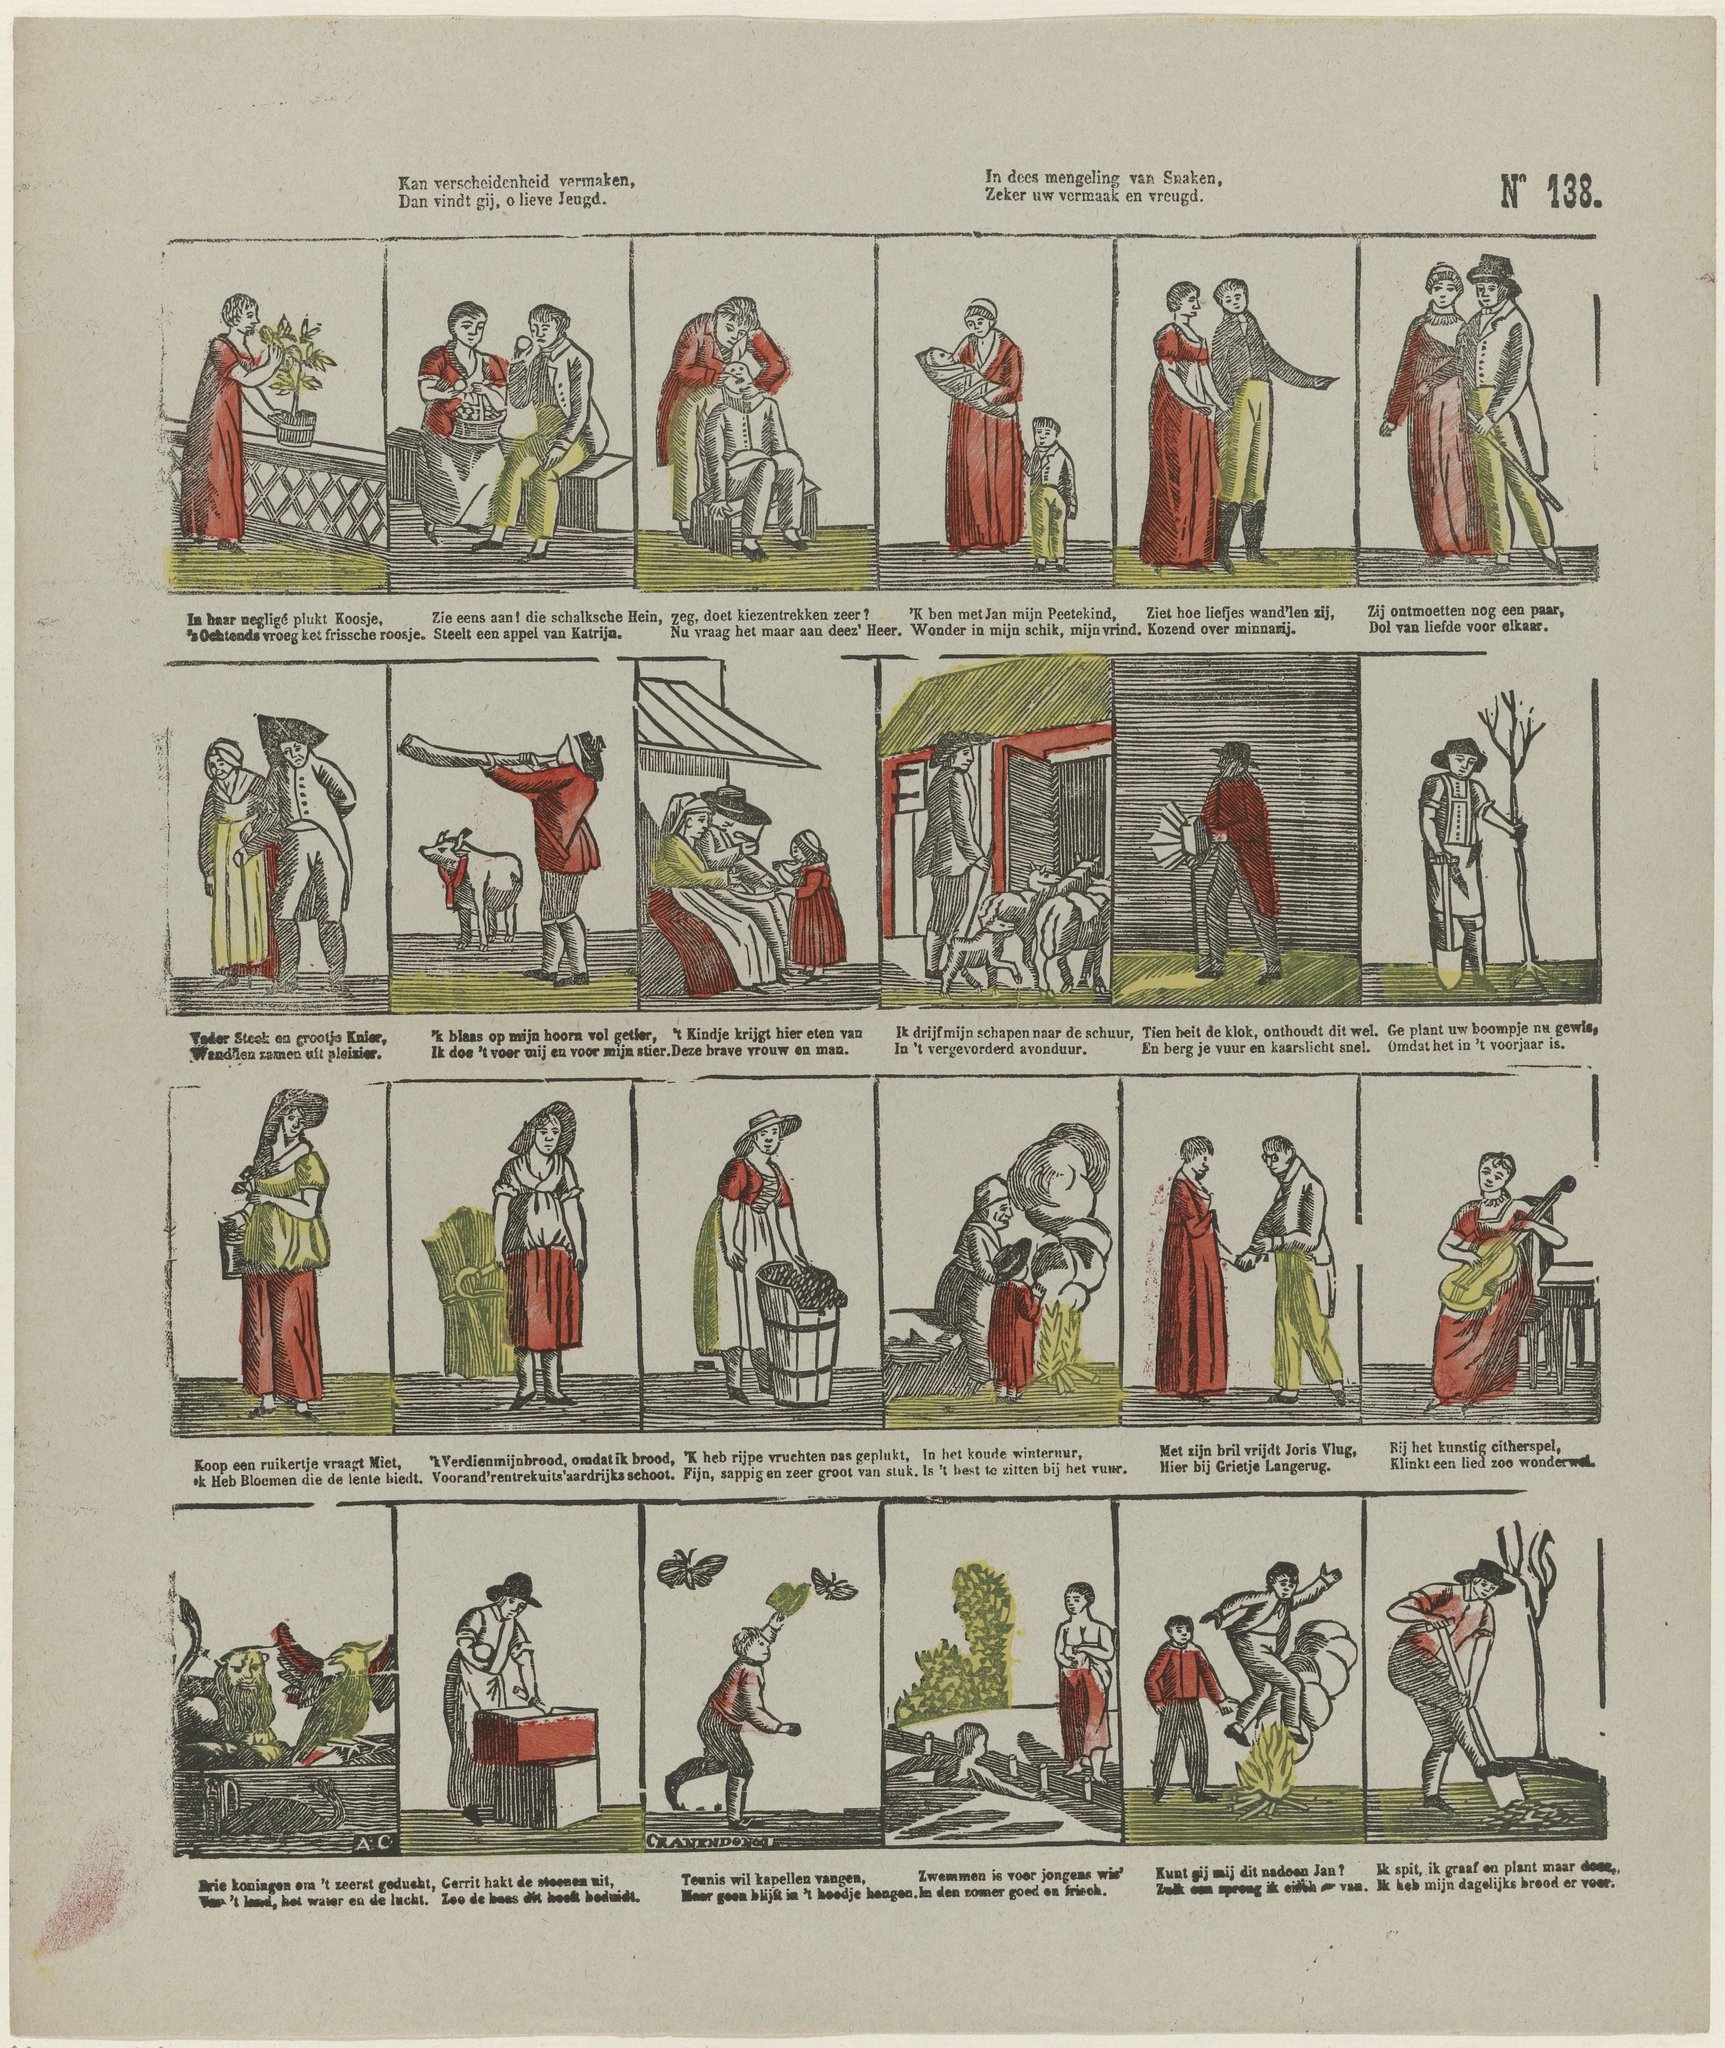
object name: print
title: Kan verscheidenheid vermaken, / Dan vindt gij, o lieve jeugd / In dees mengeling van snaken, / Zeker uw vermaak en vreugd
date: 1827-1894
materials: paper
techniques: colour, letterpress printing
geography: netherlands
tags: characters (human types)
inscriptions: collector's mark: Lugt 2760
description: Blad met 24 voorstellingen van verschillende figuren en bezigheden. Onder elke afbeelding een tweeregelig vers. Genummerd rechtsboven: No 138.